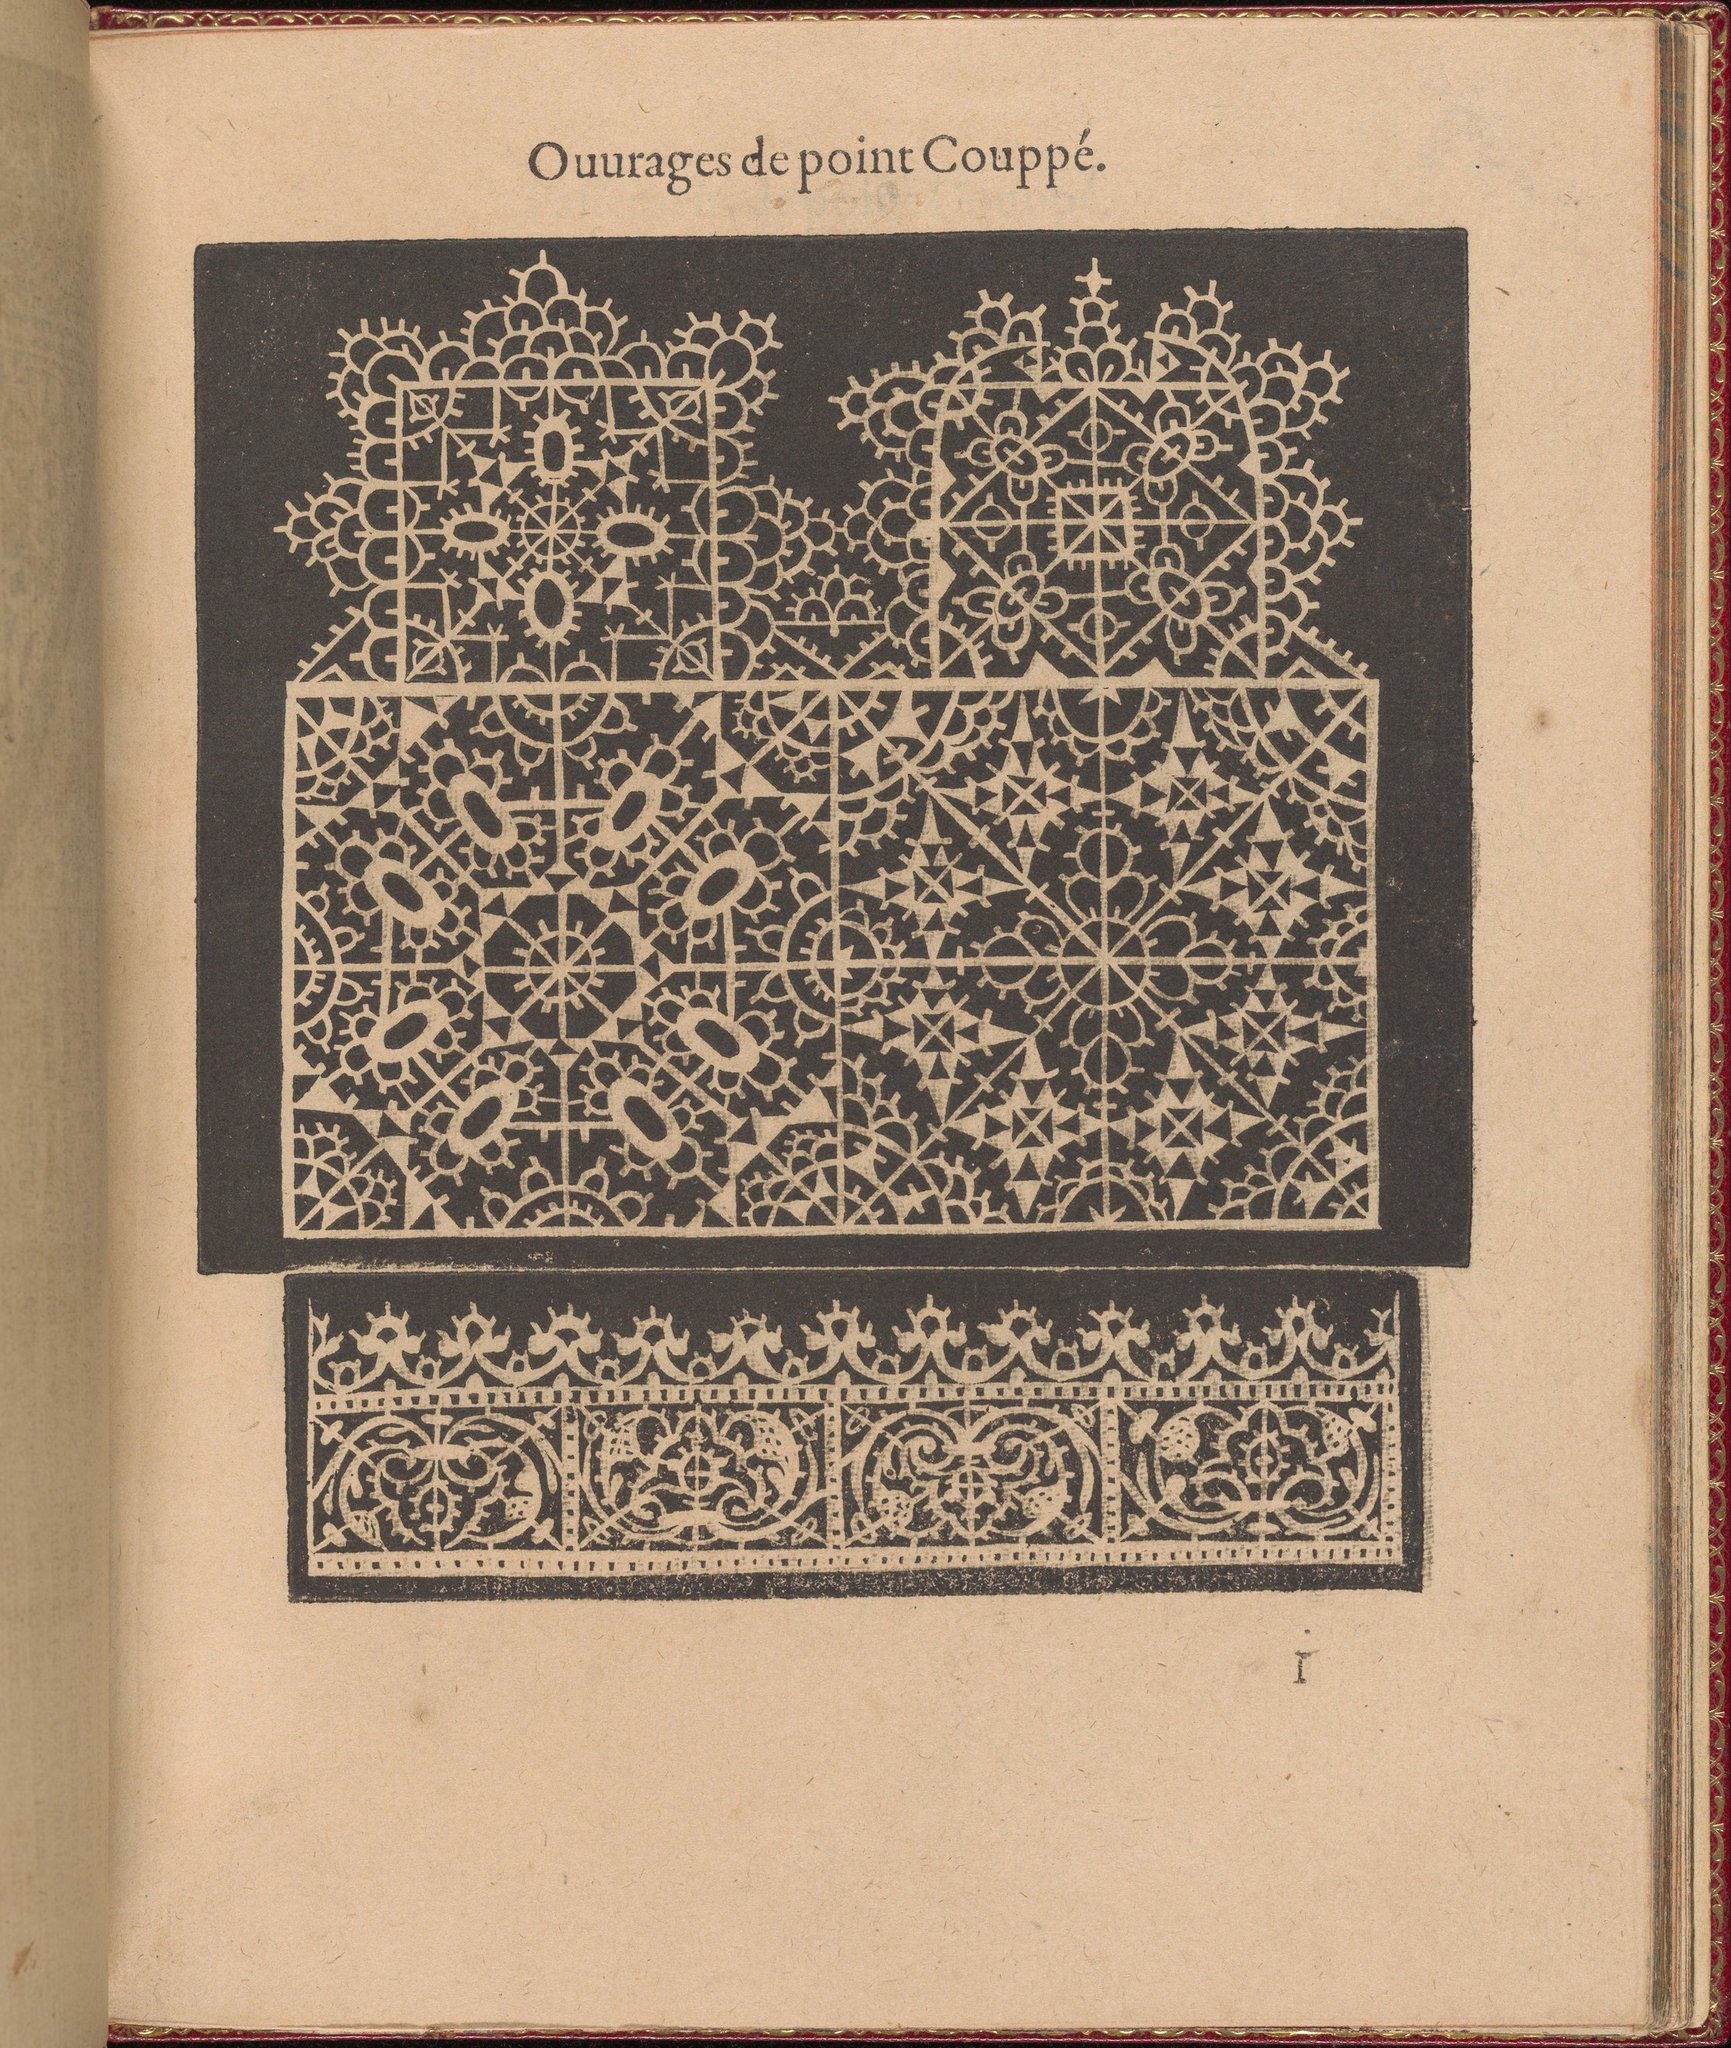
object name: book print ornament architecture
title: Les Singuliers et Nouveaux Portraicts... page 33 (recto)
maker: federico de vinciolo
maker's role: designer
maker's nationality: italian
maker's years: 1582-1599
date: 1588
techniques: woodcut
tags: ornament